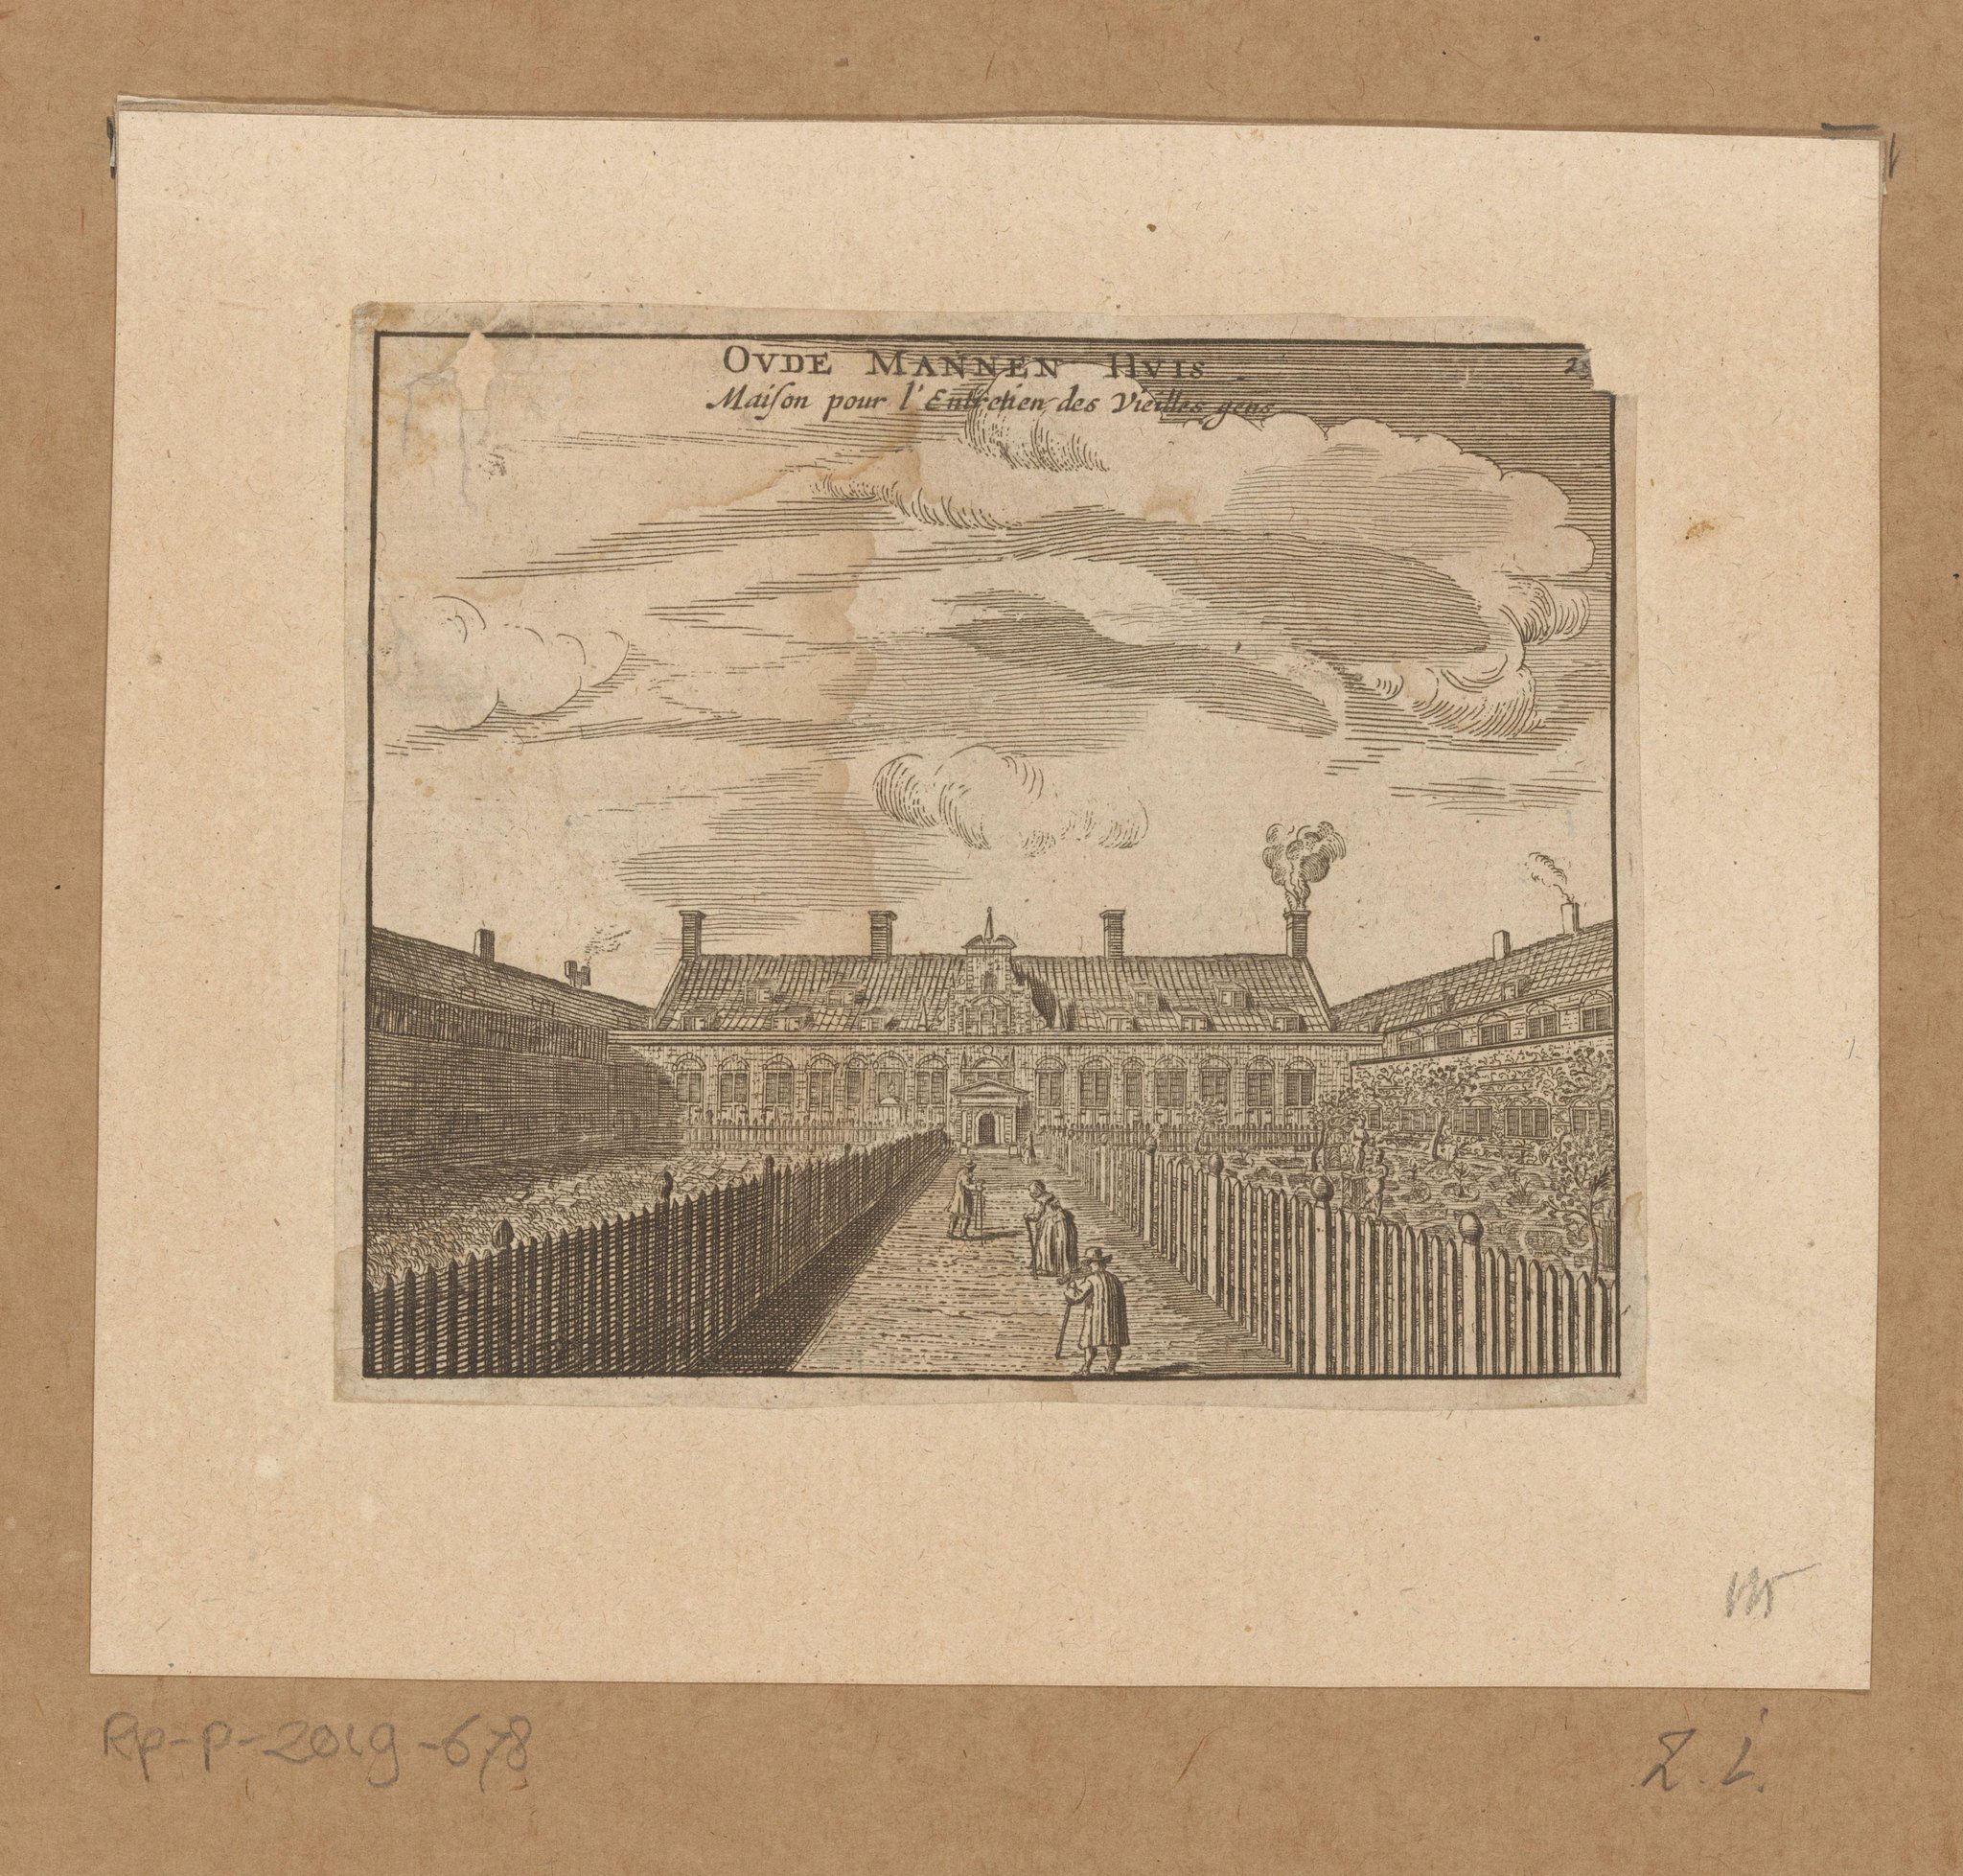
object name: book illustration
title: Gezicht op de binnenplaats van het Oudemannenhuis te Amsterdam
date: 1685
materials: paper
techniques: etching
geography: amsterdam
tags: public welfare, courtyard, old-people's home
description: Prent uit: Alle de voornaamste gebouwen der wijtvermaarde koopstad Amsterdam (…) / Tous les principaux batimens de la fameuse ville d'Amsterdam (…). Amsterdam: Hieronymus Sweerts et al., [ca. 1685]. Eerdere staten gebruikt in publicaties in 1664 en 1665.